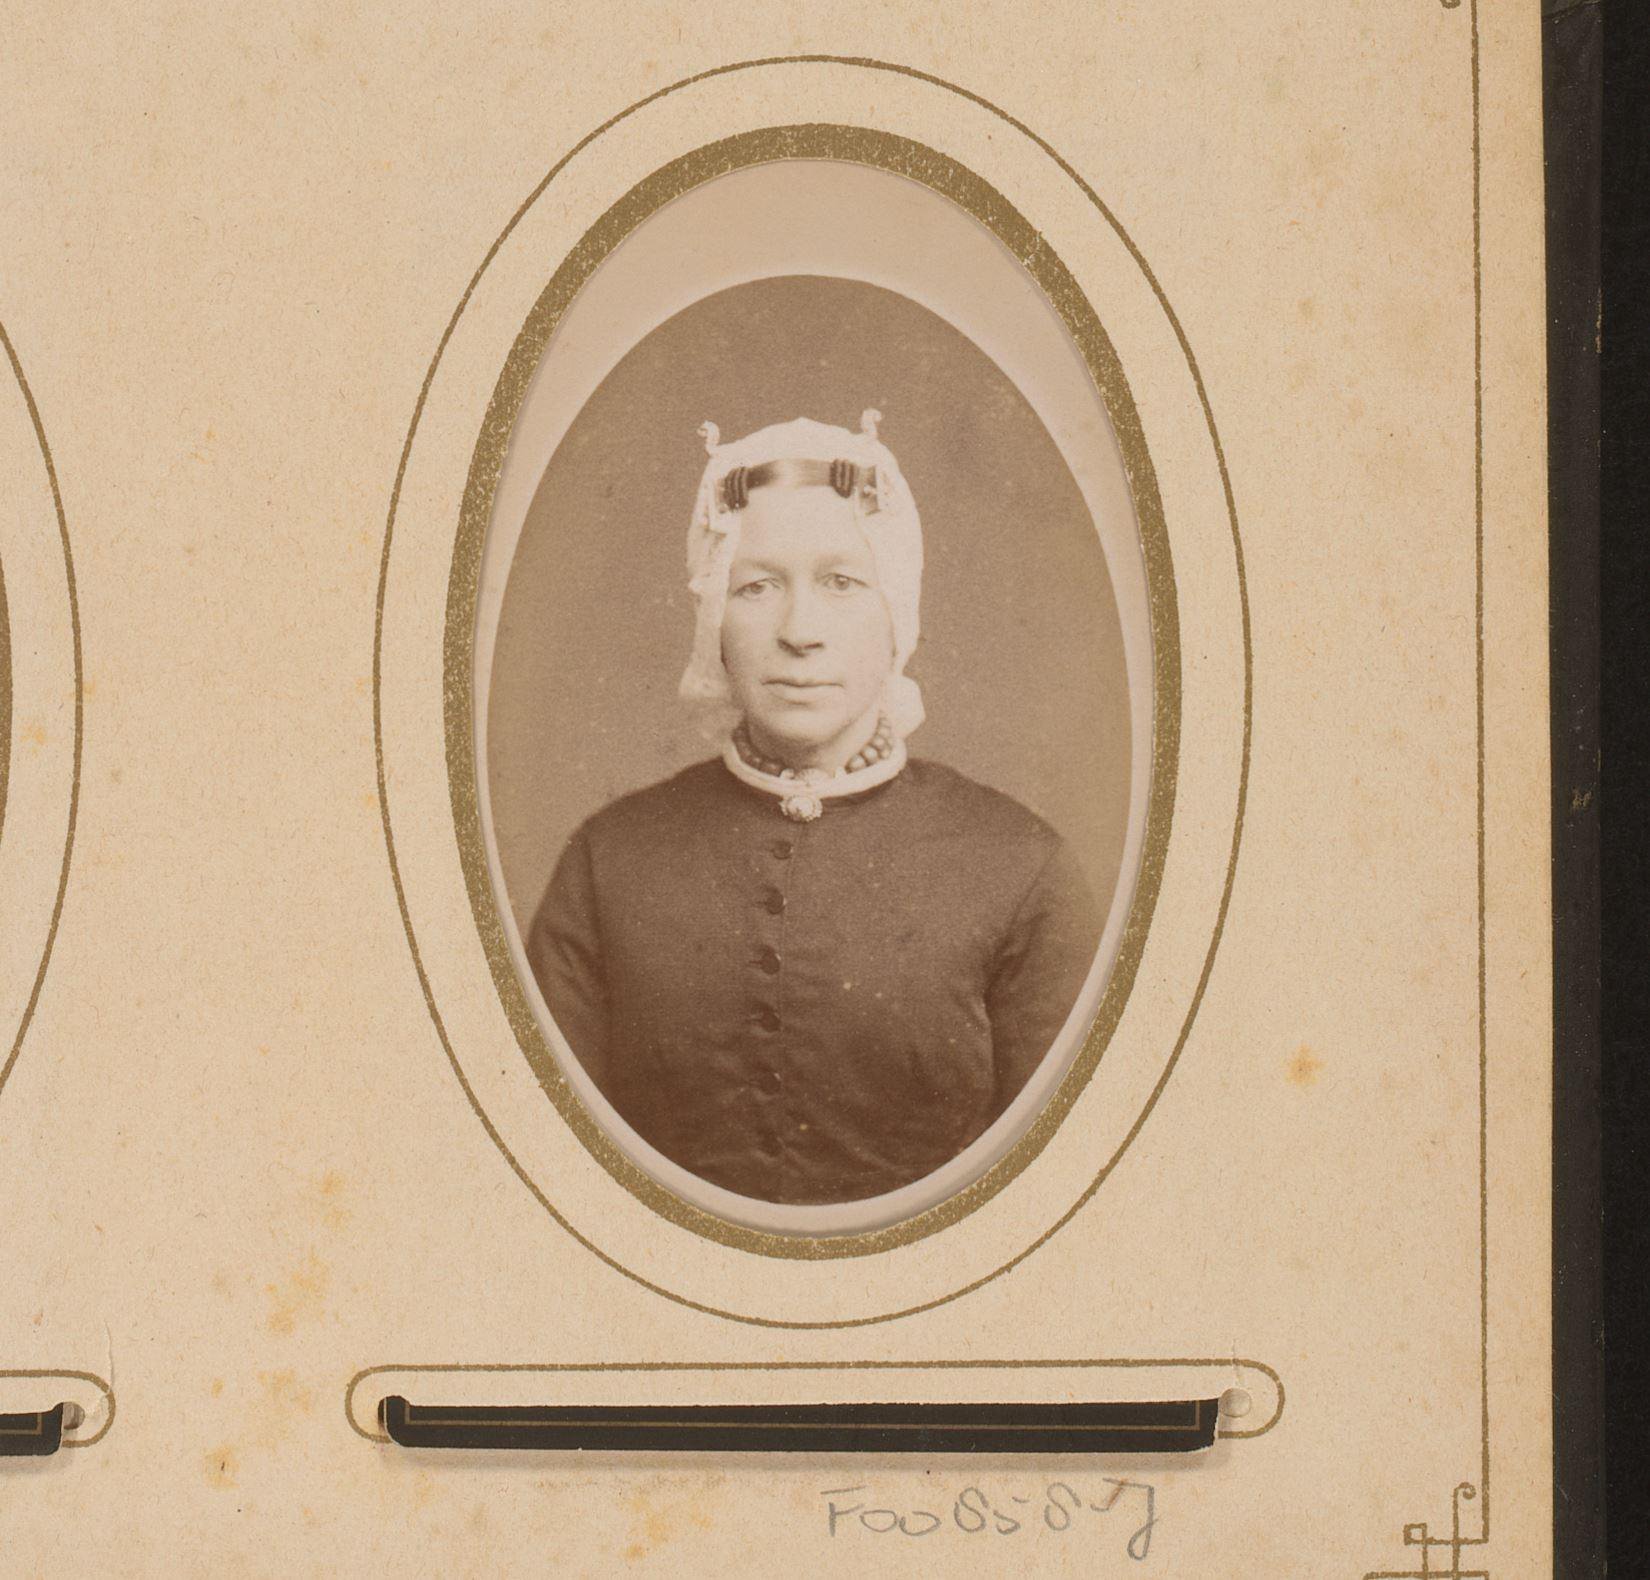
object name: photograph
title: Portret van een vrouw met muts, gelijkend op Friese kap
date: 1884-1895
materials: cardboard, photographic support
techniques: albumen print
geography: alkmaar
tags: historical persons - bb - woman, head-gear: cap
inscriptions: inscription: ‘Alkmaar, Verdronken Oord; Helder, Kanaalweg 99’